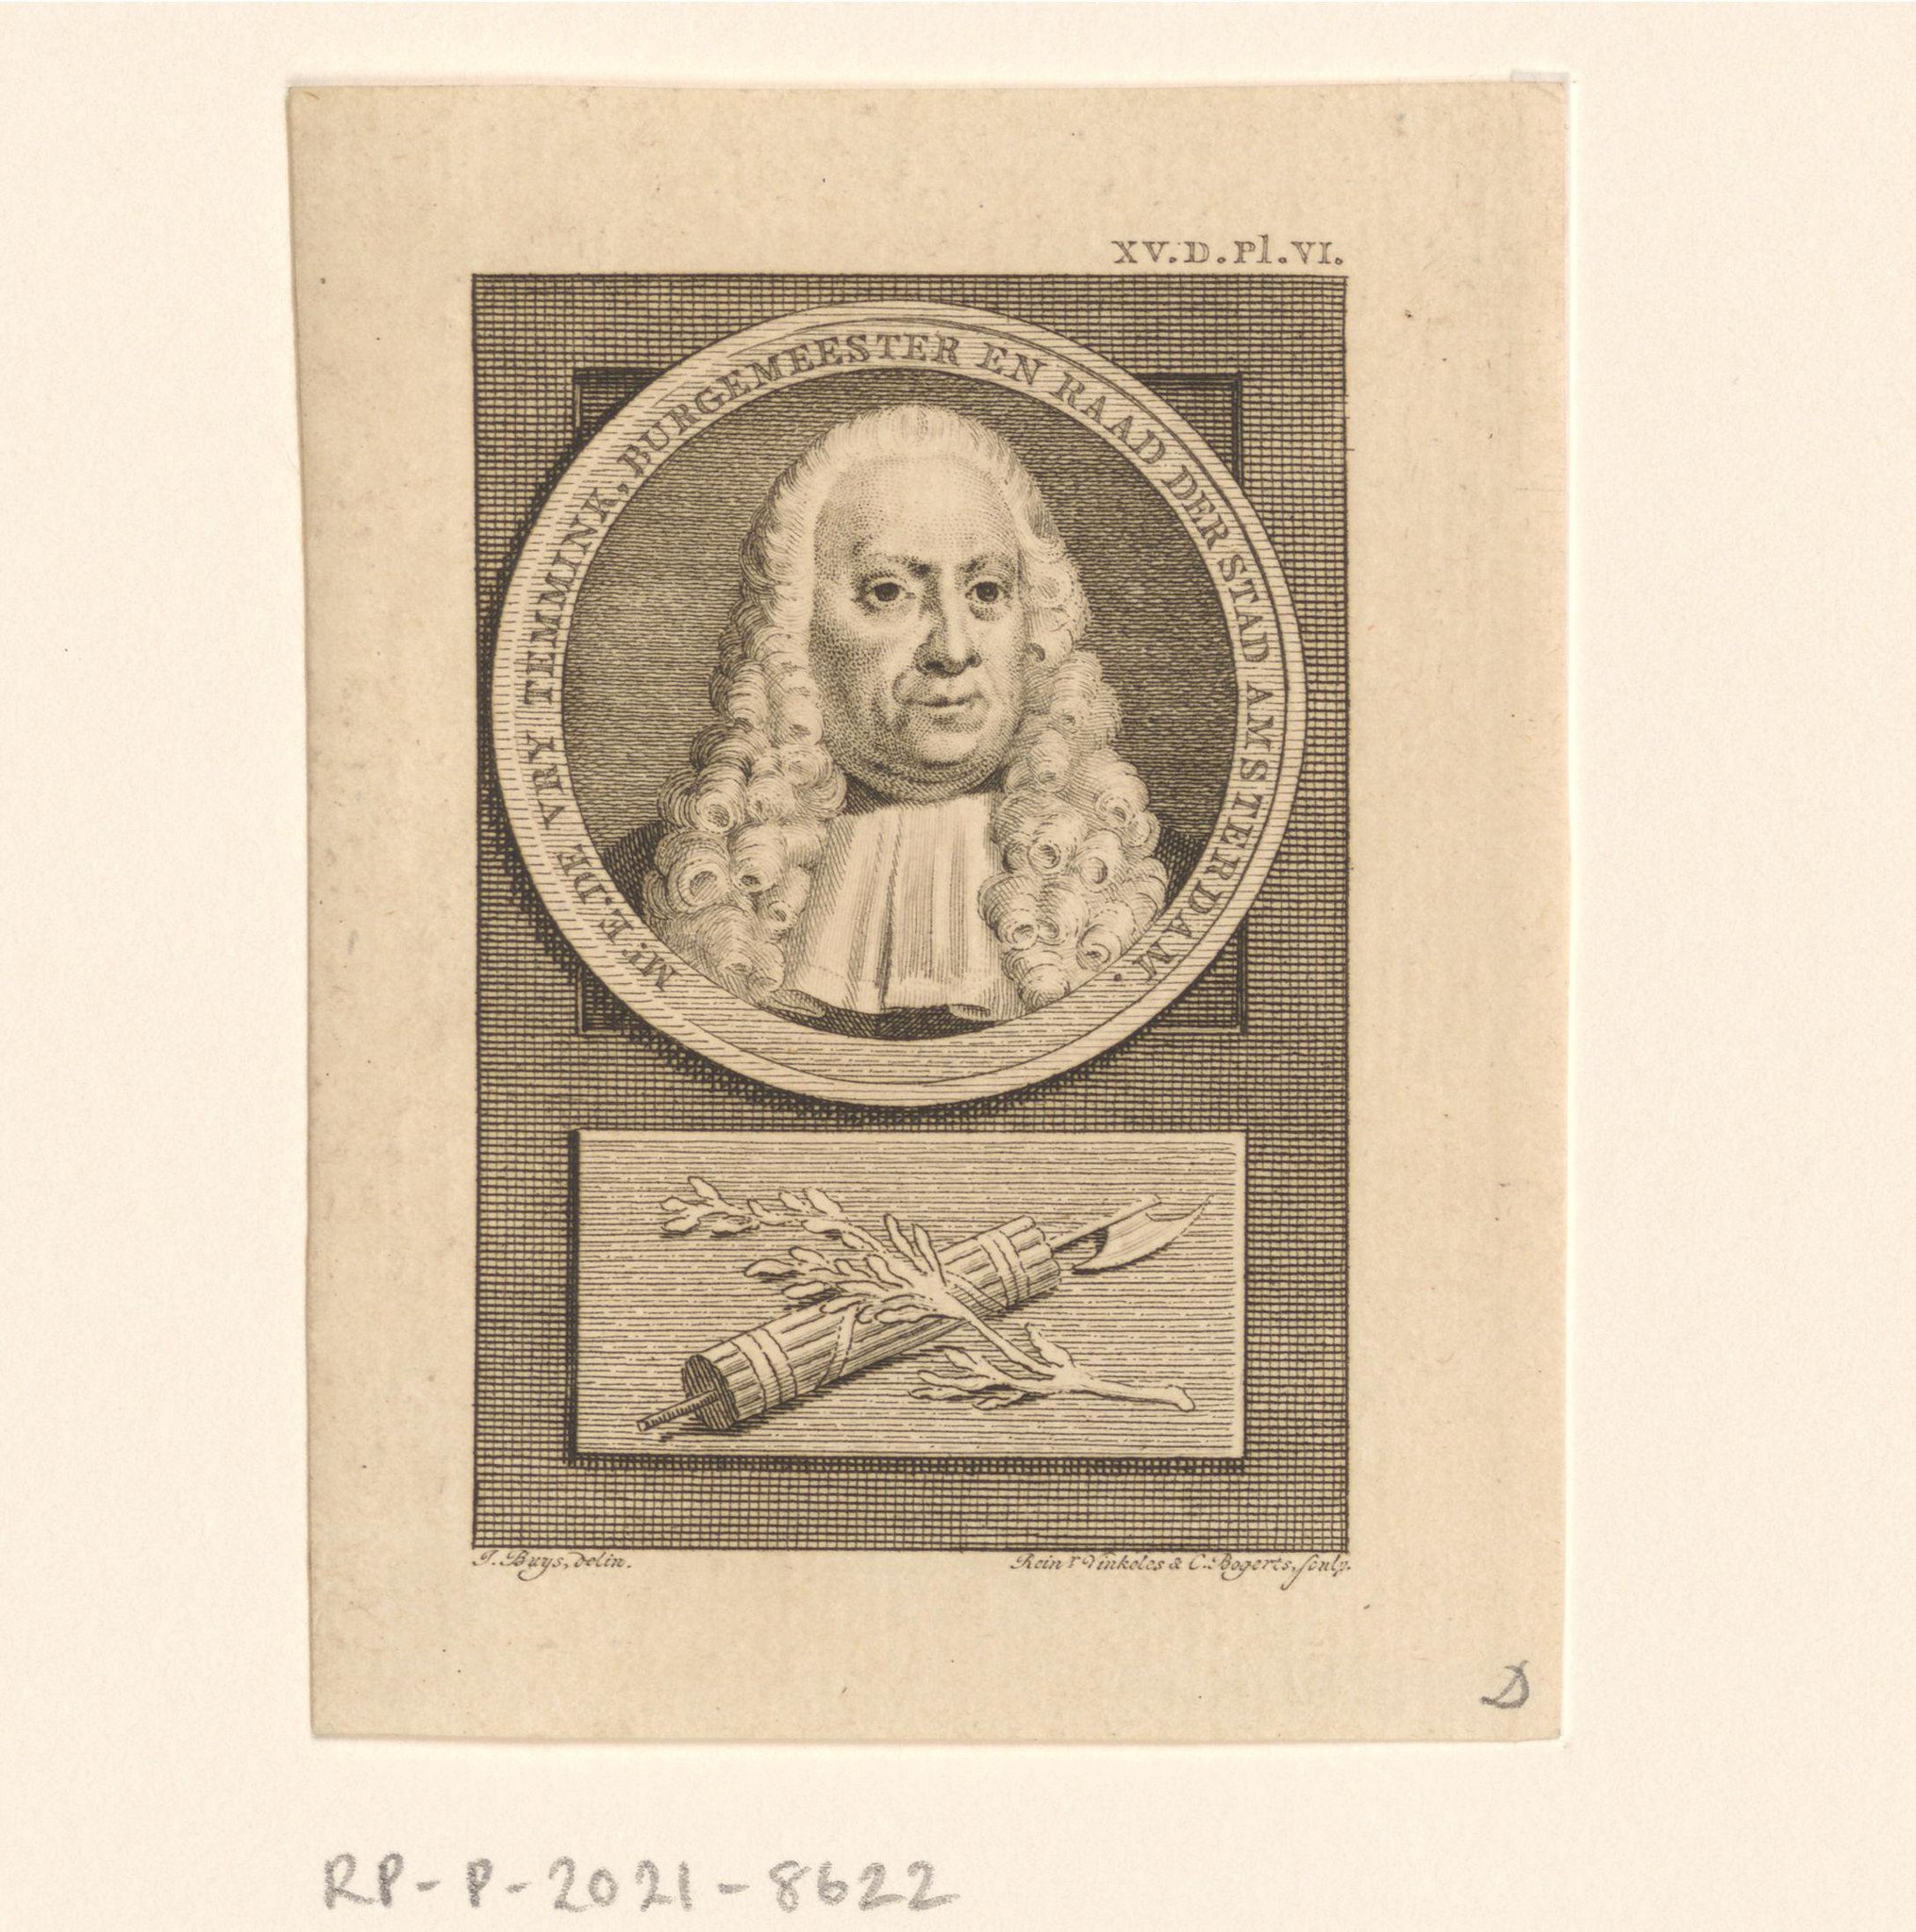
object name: book illustration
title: Portret van Egbert de Vrij Temminck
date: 1783-1795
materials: paper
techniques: engraving, etching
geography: amsterdam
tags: mayor, egbert de vrij temminck, mayor, burgomaster, historical persons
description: Prent uit: Fokke, Jan. Geschiedenissen der Vereenigde Nederlanden voor de vaderlandsche jeugd (...). Amsterdam: Johannes Allart, 1783-1795, dl. 15.